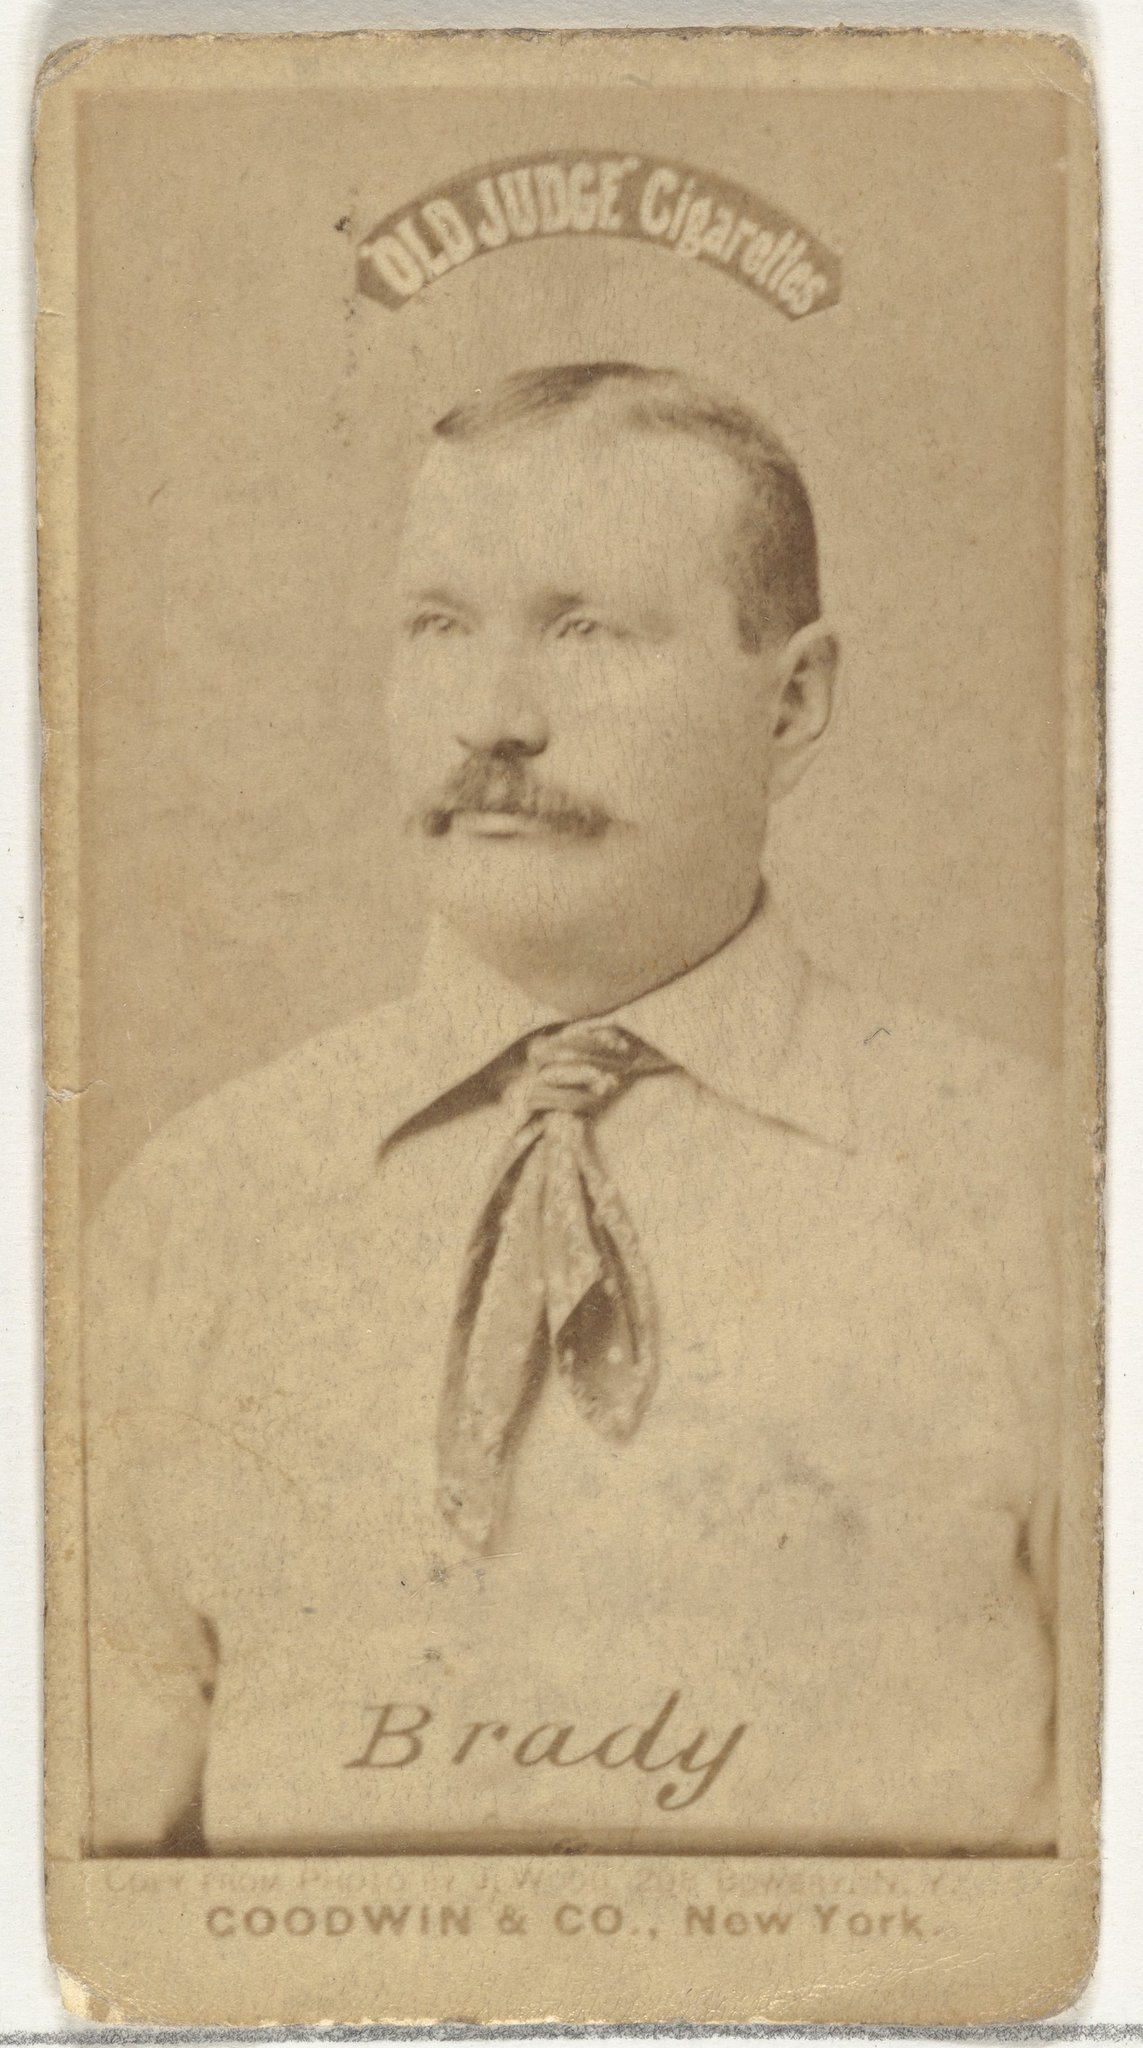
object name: baseball card, photograph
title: Stephen A. "Steve" Brady, New York Metropolitans, from the Old Judge series (N172) for Old Judge Cigarettes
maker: goodwin & company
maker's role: publisher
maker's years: 1850-1950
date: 1887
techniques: albumen silver print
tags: men,portraits,baseball,athletes